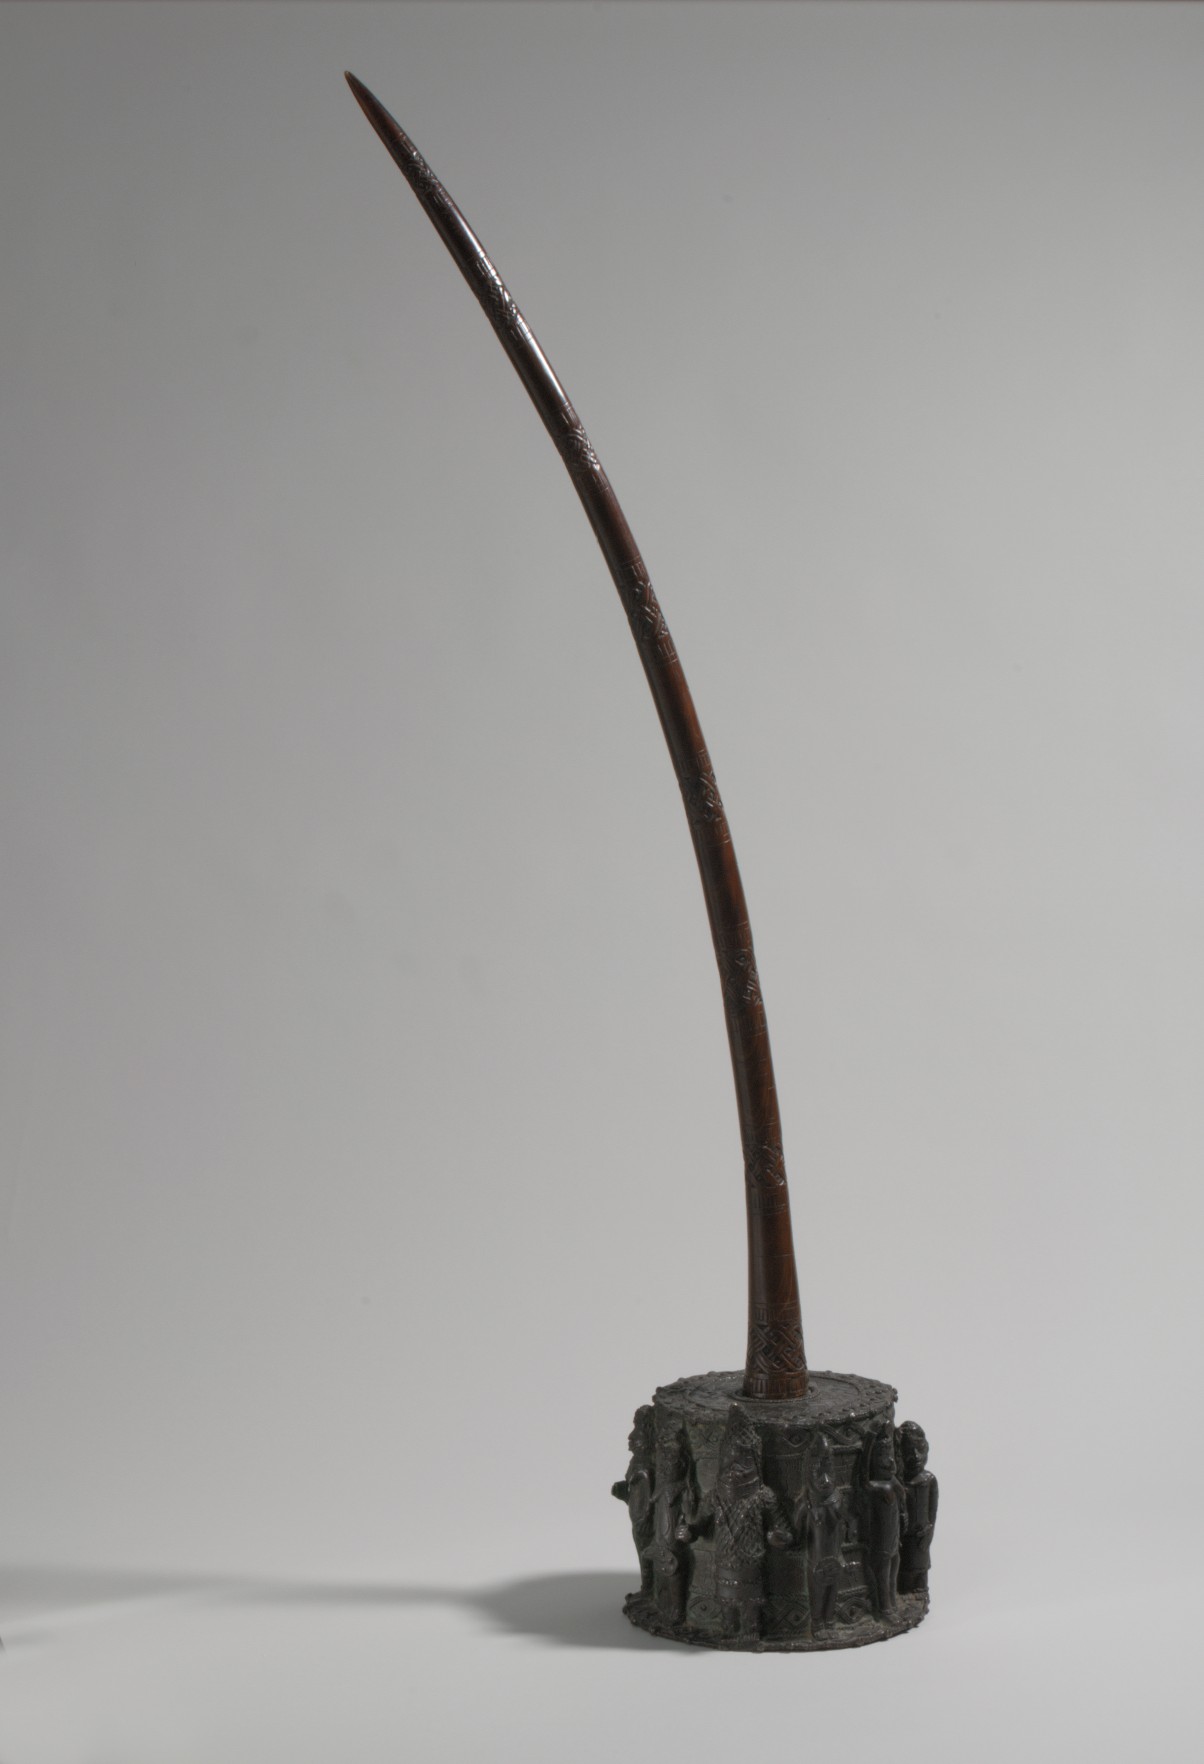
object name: altar tusk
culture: edo period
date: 1701-1900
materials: ivory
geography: nigeria